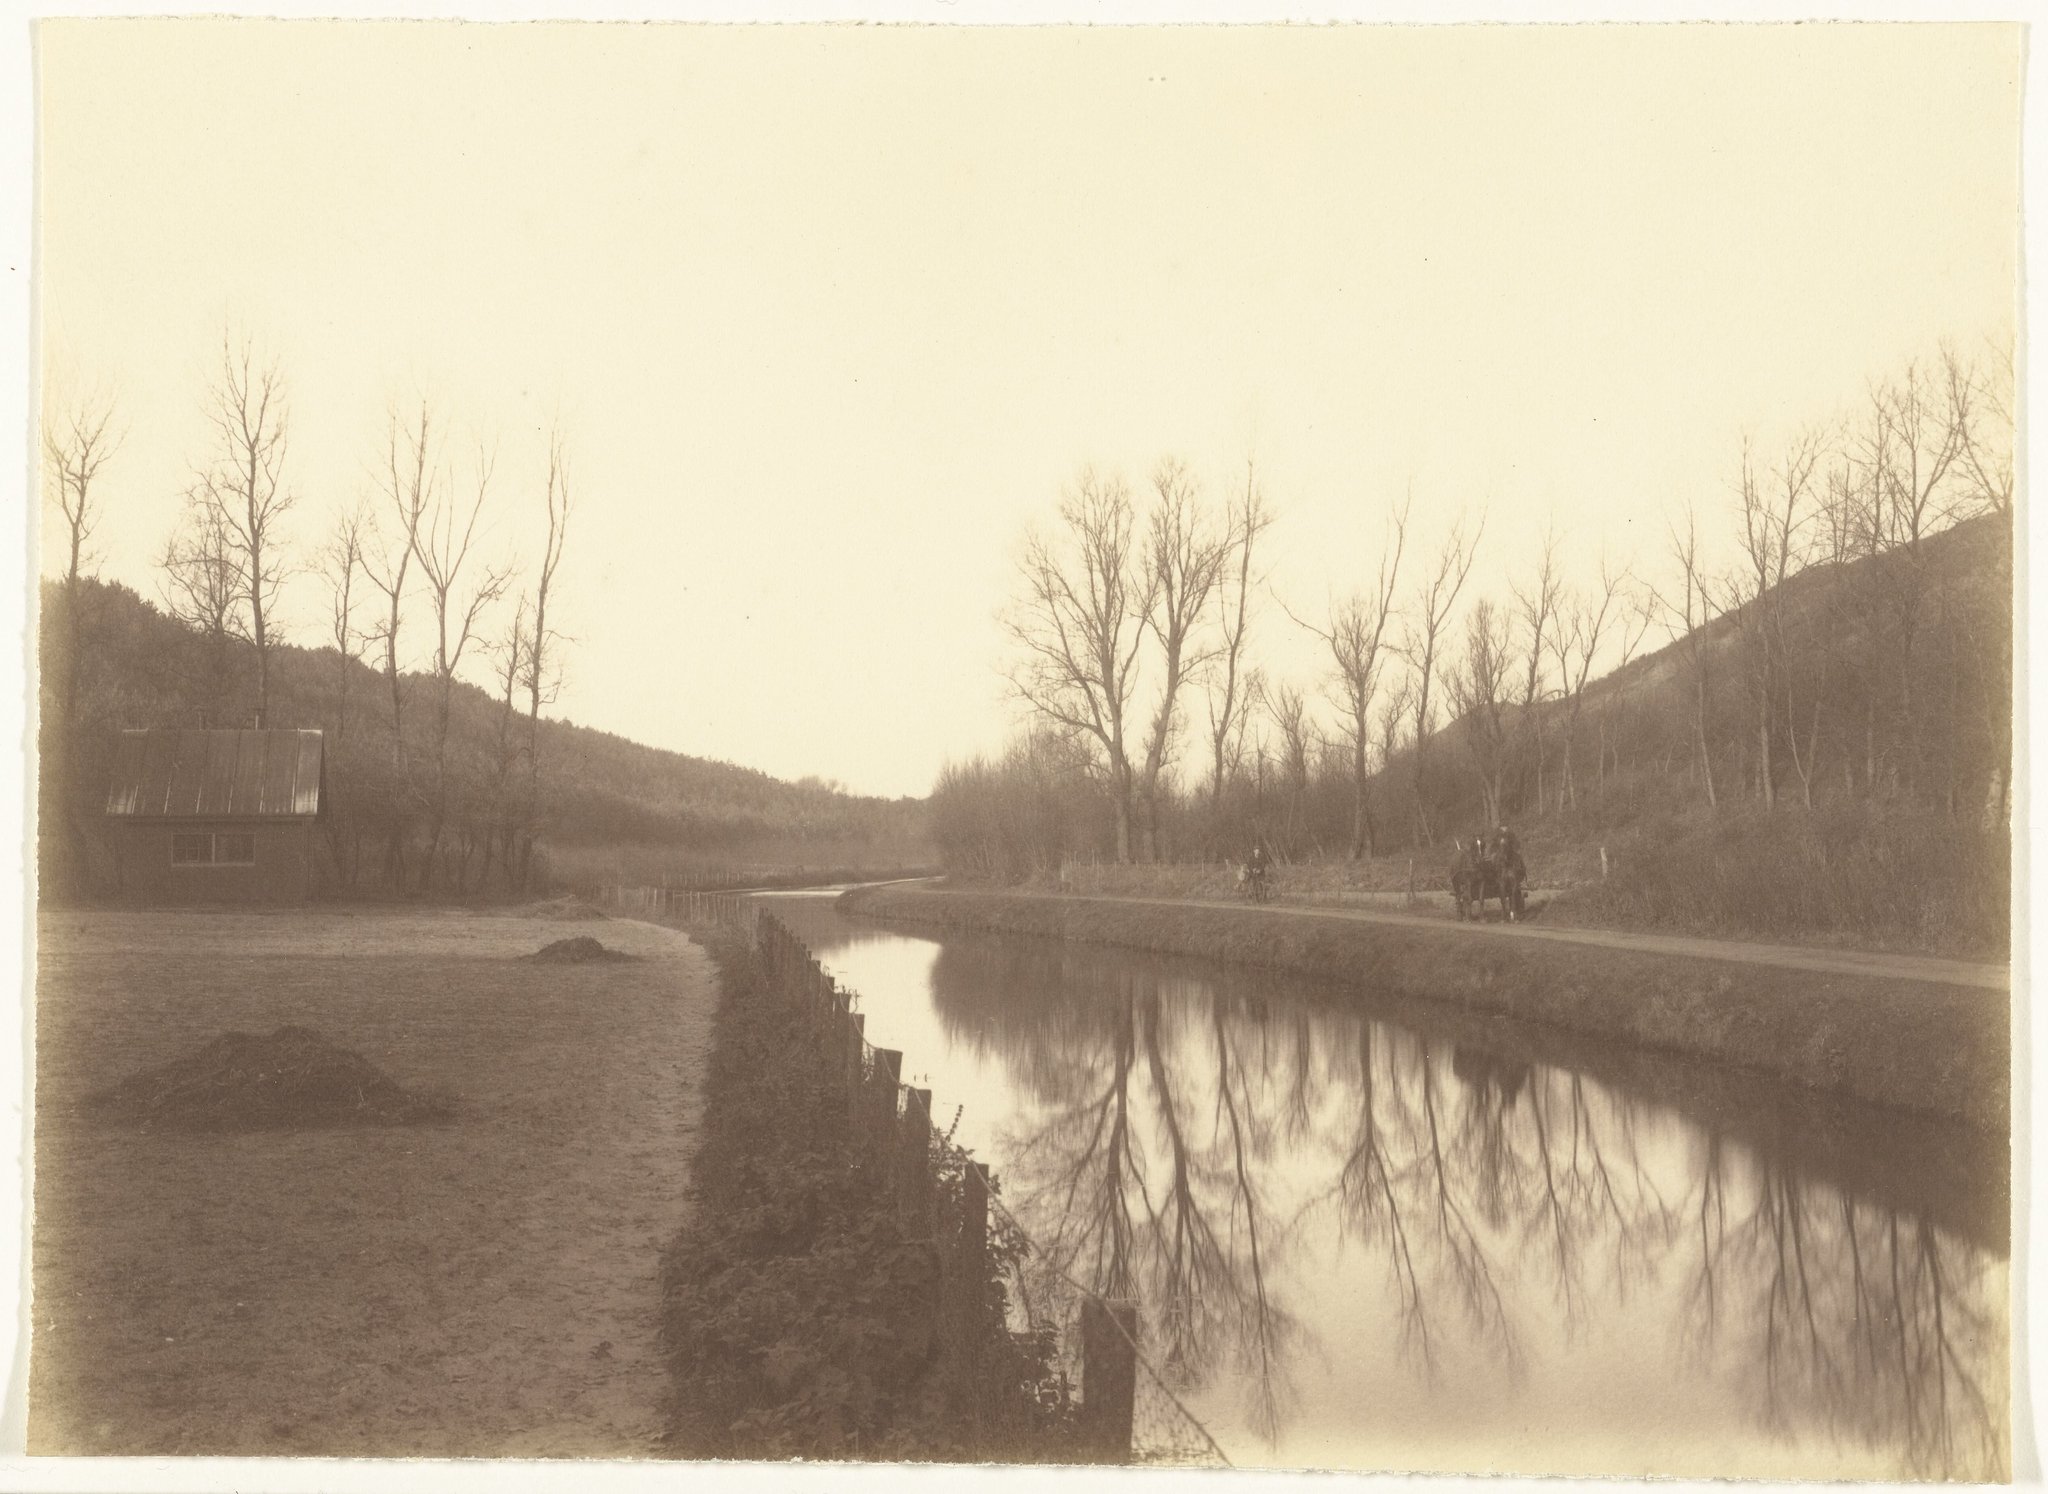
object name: photograph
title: Paard met wagen en fietser langs een vaart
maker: richard tepe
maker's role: fotograaf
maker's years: 1864-1952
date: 1900-1930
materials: photographic support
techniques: albumen print, salted paper print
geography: netherlands